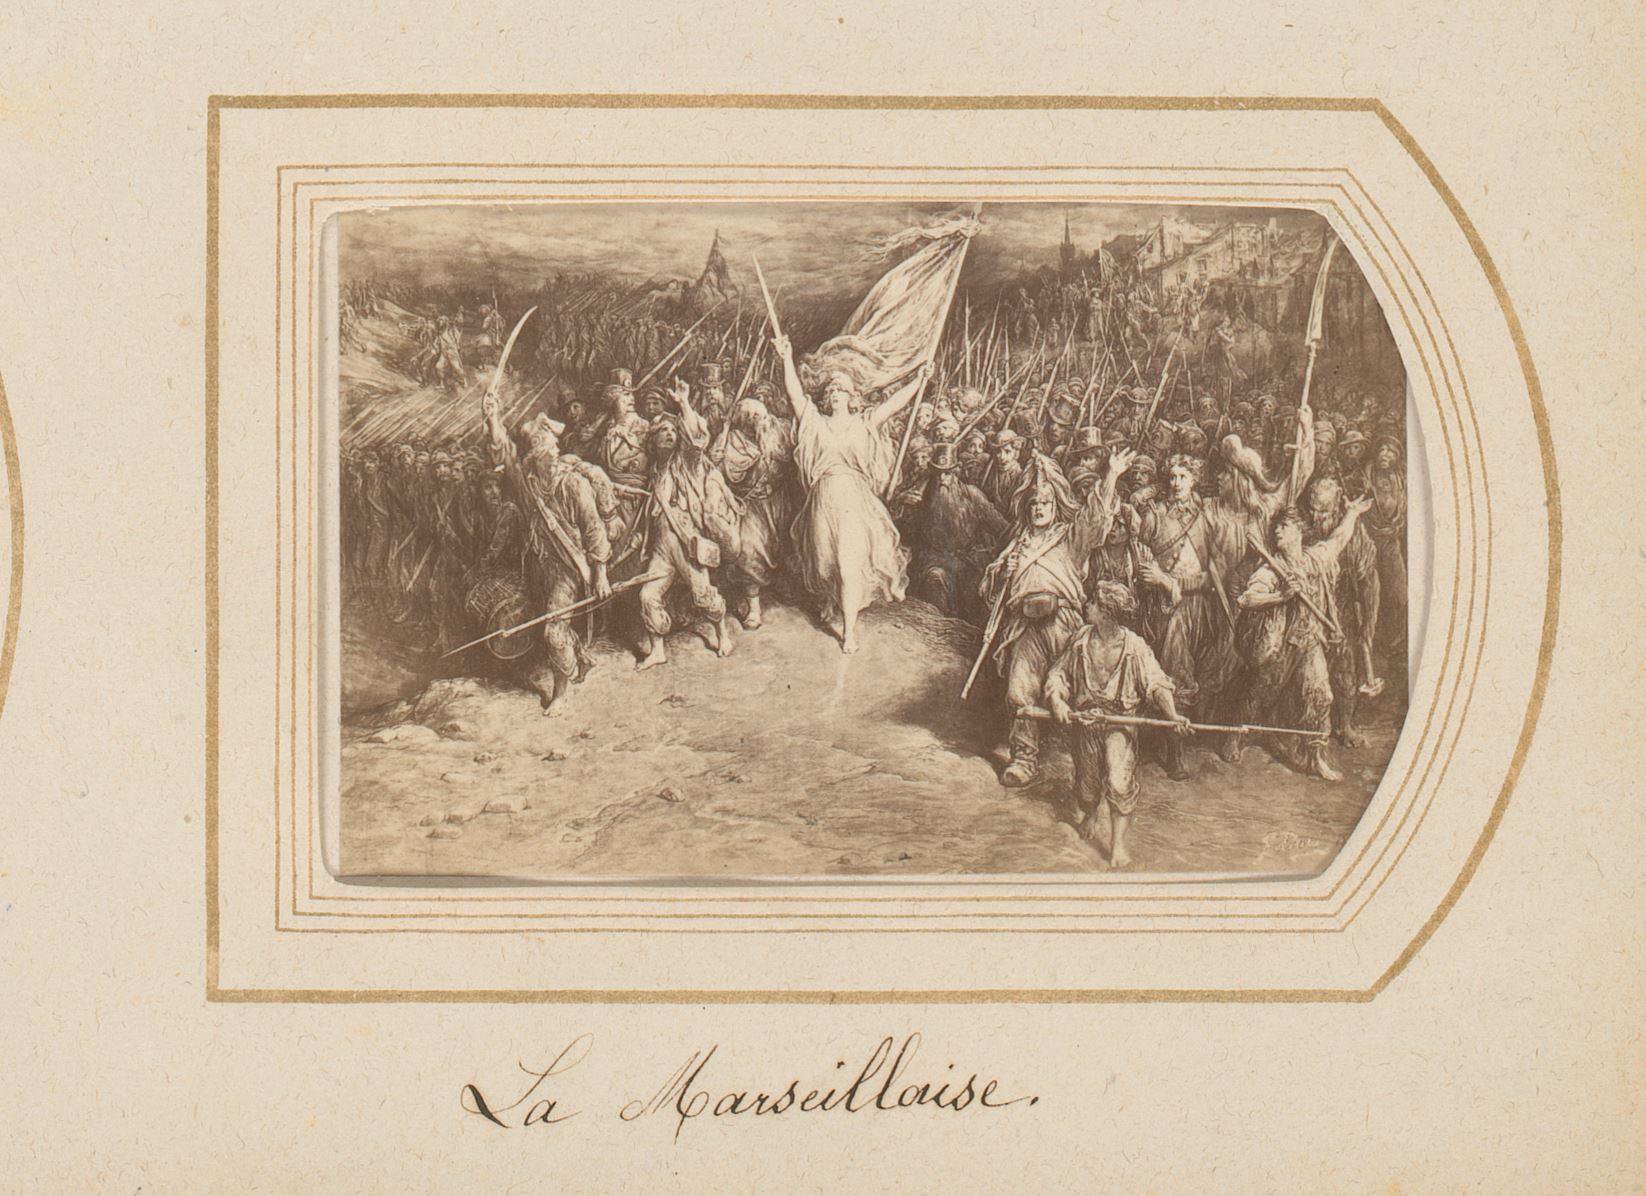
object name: photograph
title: Fotoreproductie van La Marseillaise door Gustave Doré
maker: Anonymous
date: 1870-1890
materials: cardboard, photographic support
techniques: albumen print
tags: crowd, mob, painting, drawing and the graphic arts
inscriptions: inscription: ‘[...]’, annotation: ‘La Marseillaise’